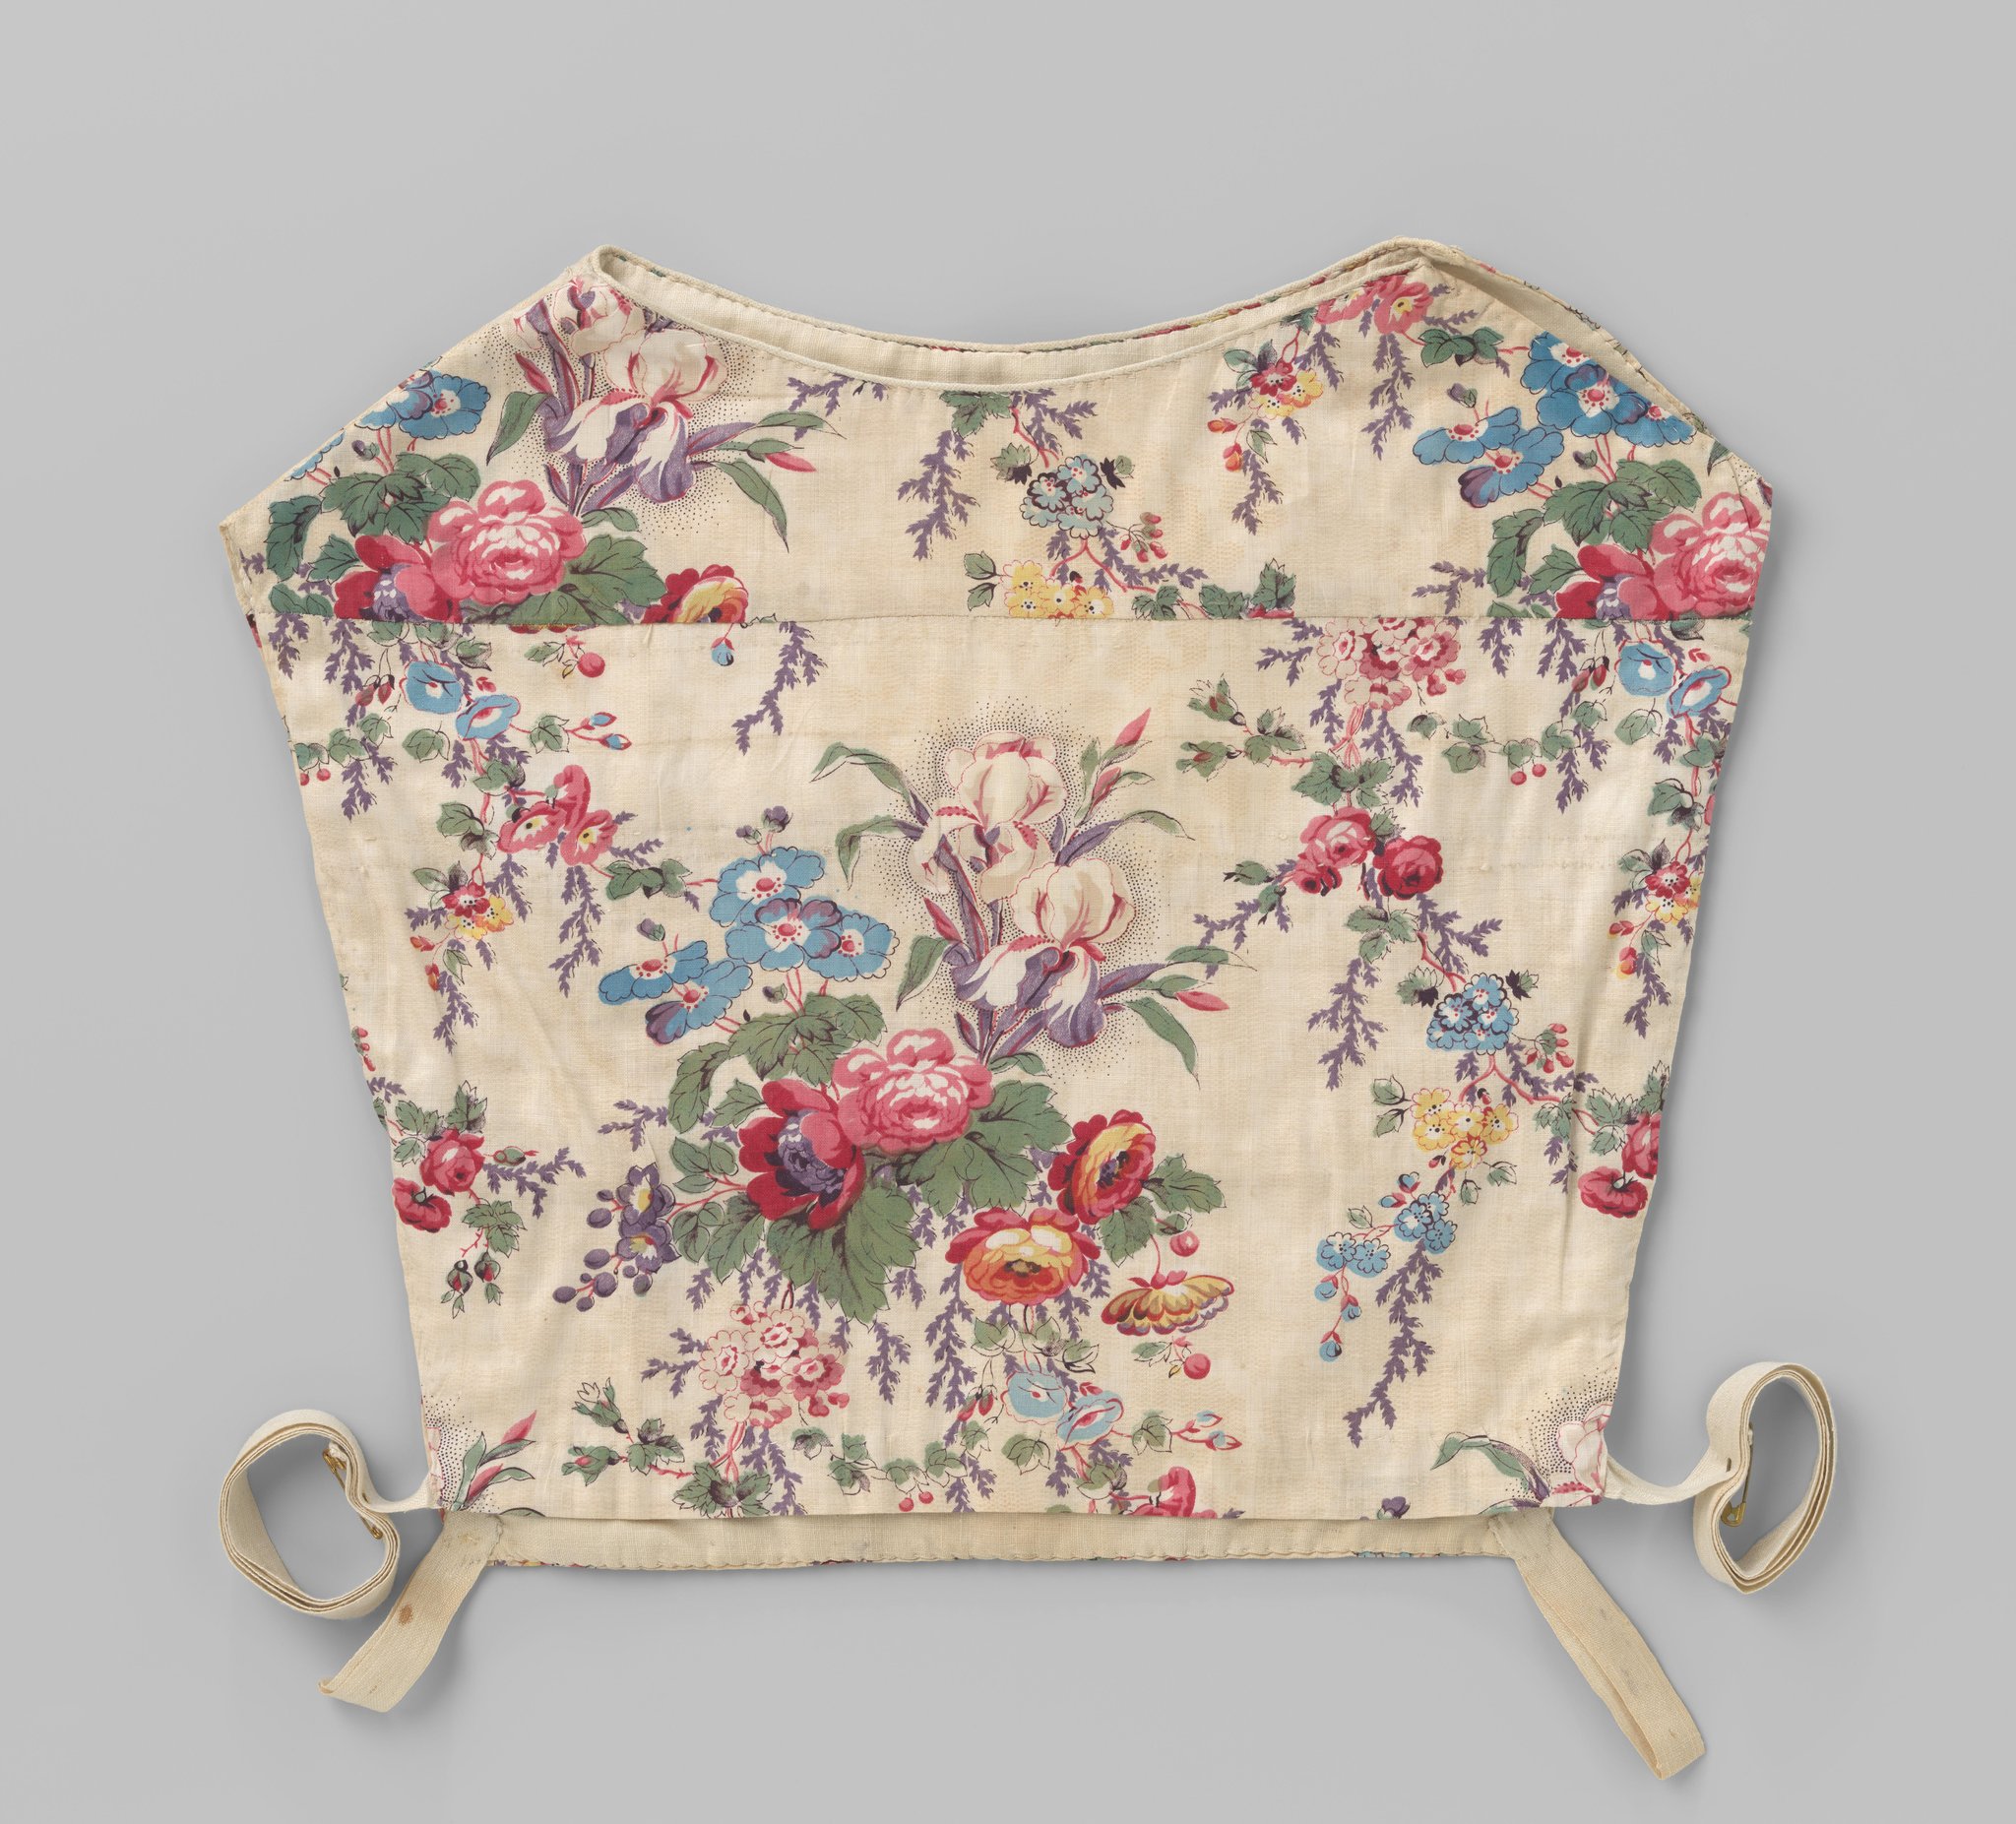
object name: corsage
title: Lijfje bedrukt met veelkleurige bloemen gedrukt op wit fond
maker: Anonymous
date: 1880-1940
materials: textile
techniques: printing, weave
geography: netherlands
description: Het lijf is aan de binnenzijde wit gevoerd. Een schouder is gelsoten, de andere zijde sluit met drie haken van metaal. Aan de voorzijde in beide hoeken aan de onderzijde een lus, aan de achterzijde een wit lint.